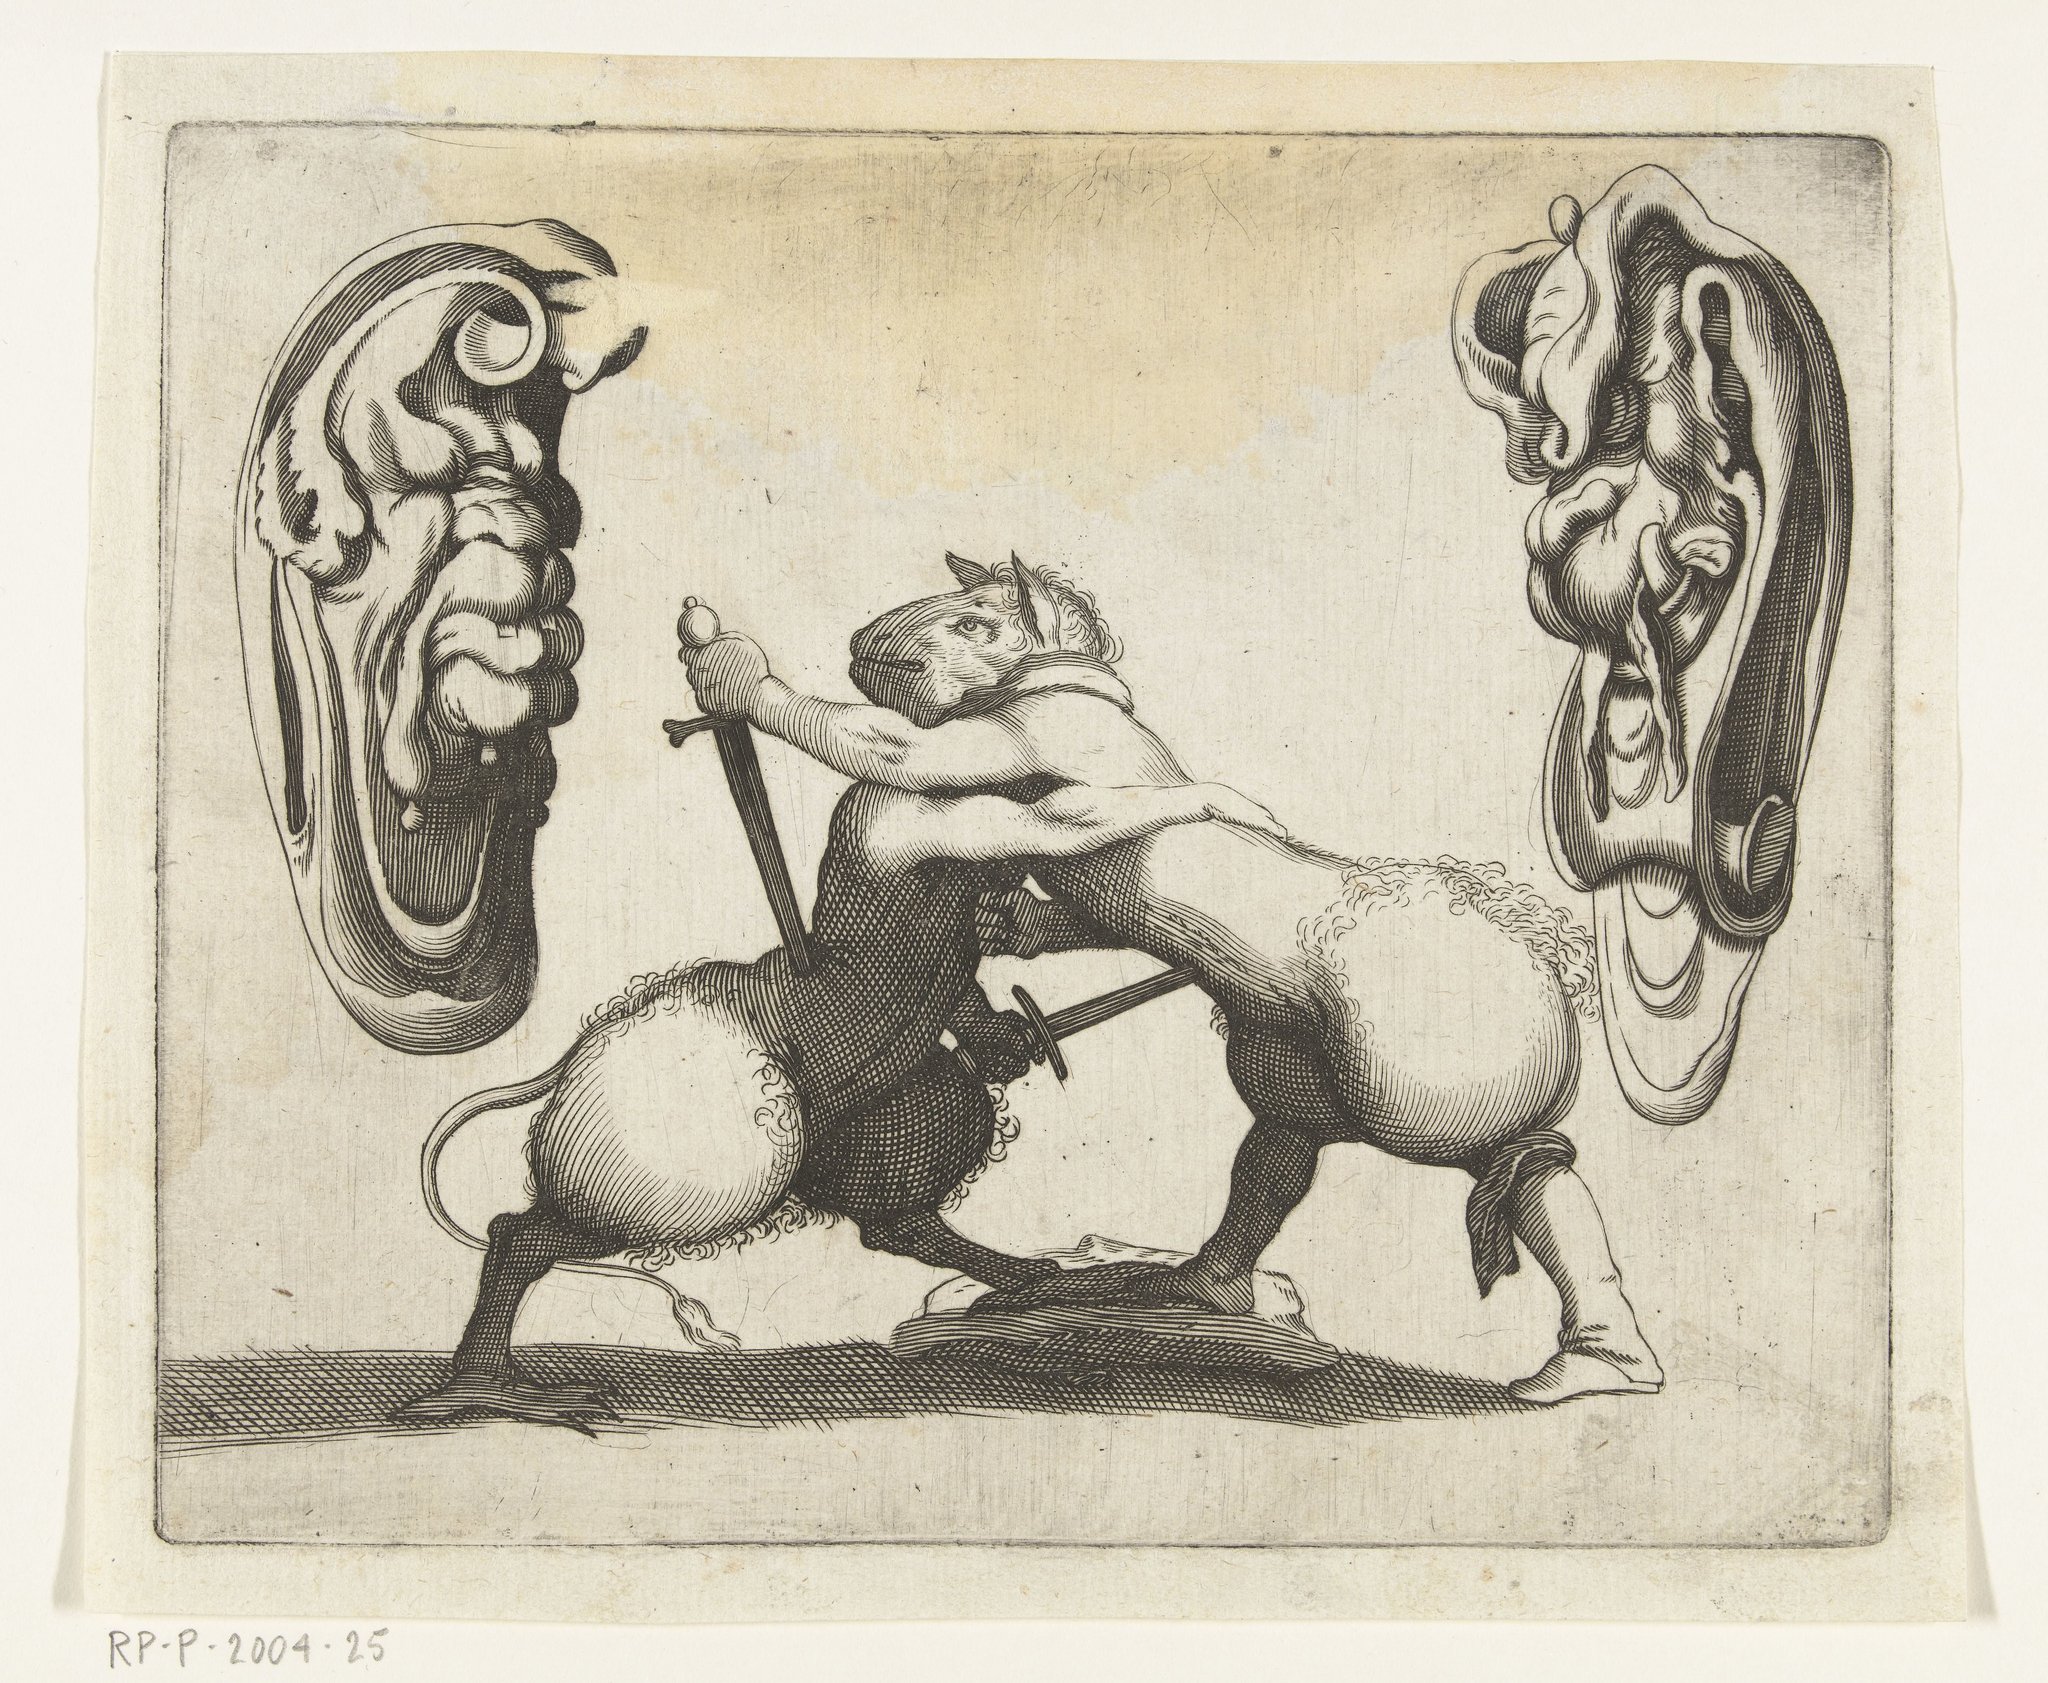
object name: print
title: Twee vechtende groteske figuren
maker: Anonymous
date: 1600-1625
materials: paper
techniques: engraving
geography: netherlands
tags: ornament ~ grotesque, fabulous animals (sometimes wrongly called 'grotesques'); 'mostri' (ripa)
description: Twee groteske figuren bevechten elkaar met een zwaard. Links en rechts een groot oor met menselijk gezicht. Uit serie van 12